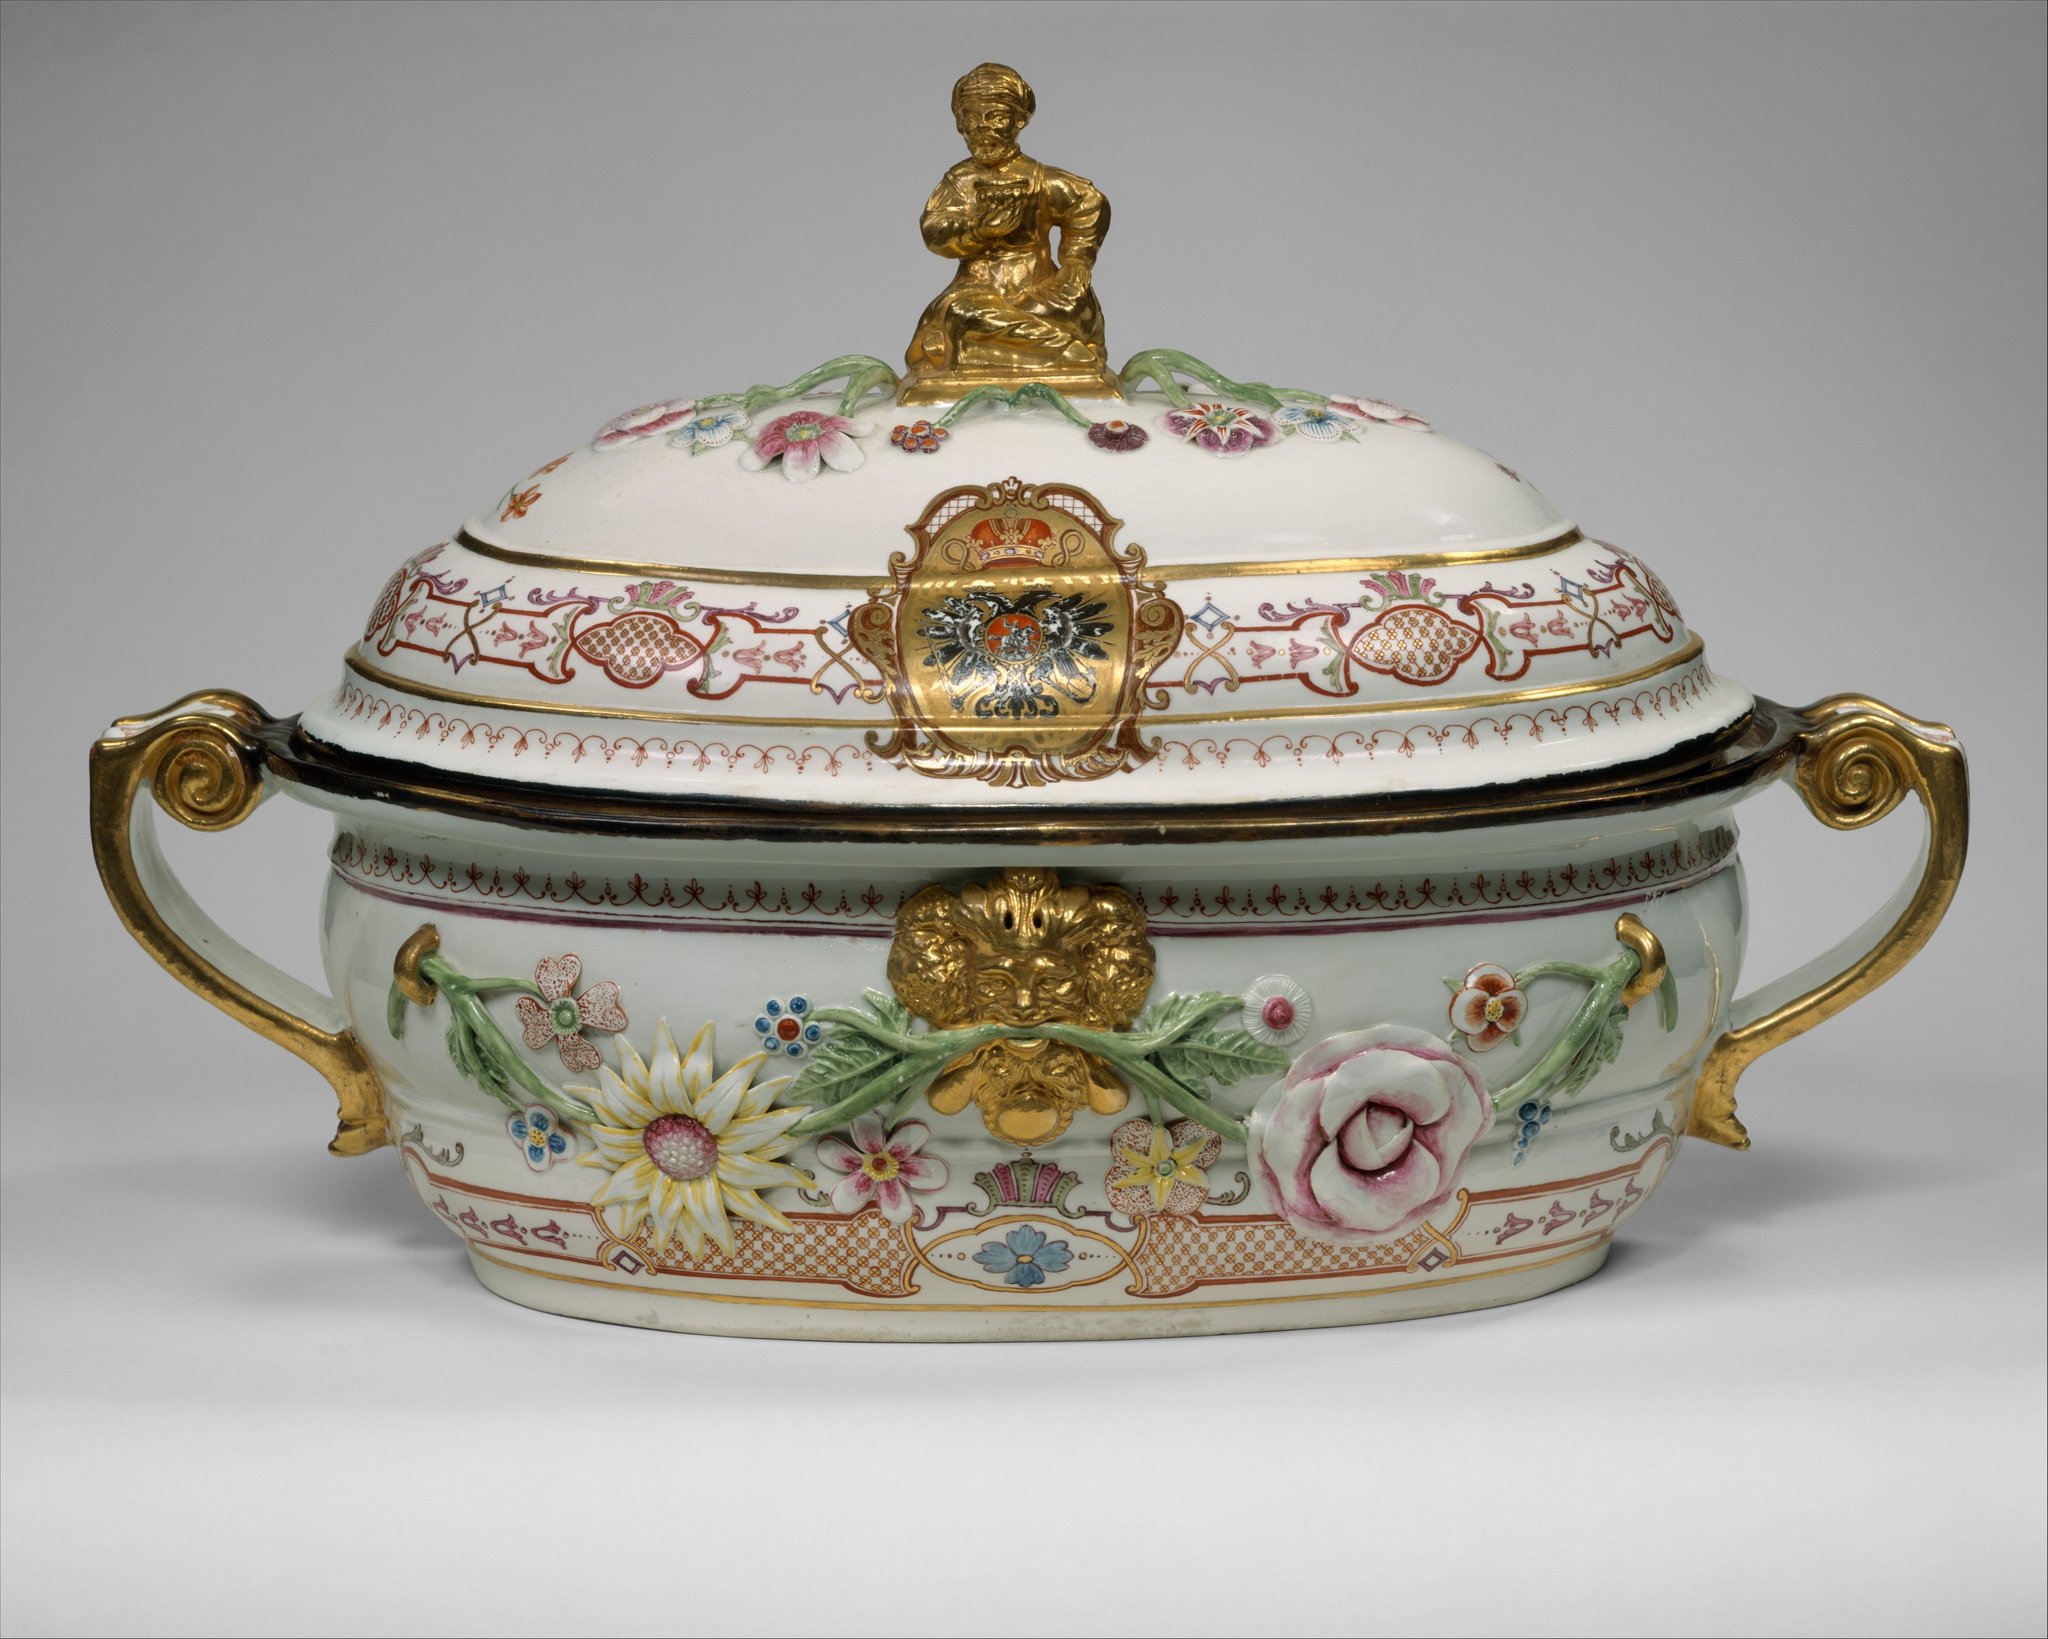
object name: tureen with cover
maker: vienna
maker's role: manufactory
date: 1735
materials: hard paste porcelain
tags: men,flowers,coat of arms